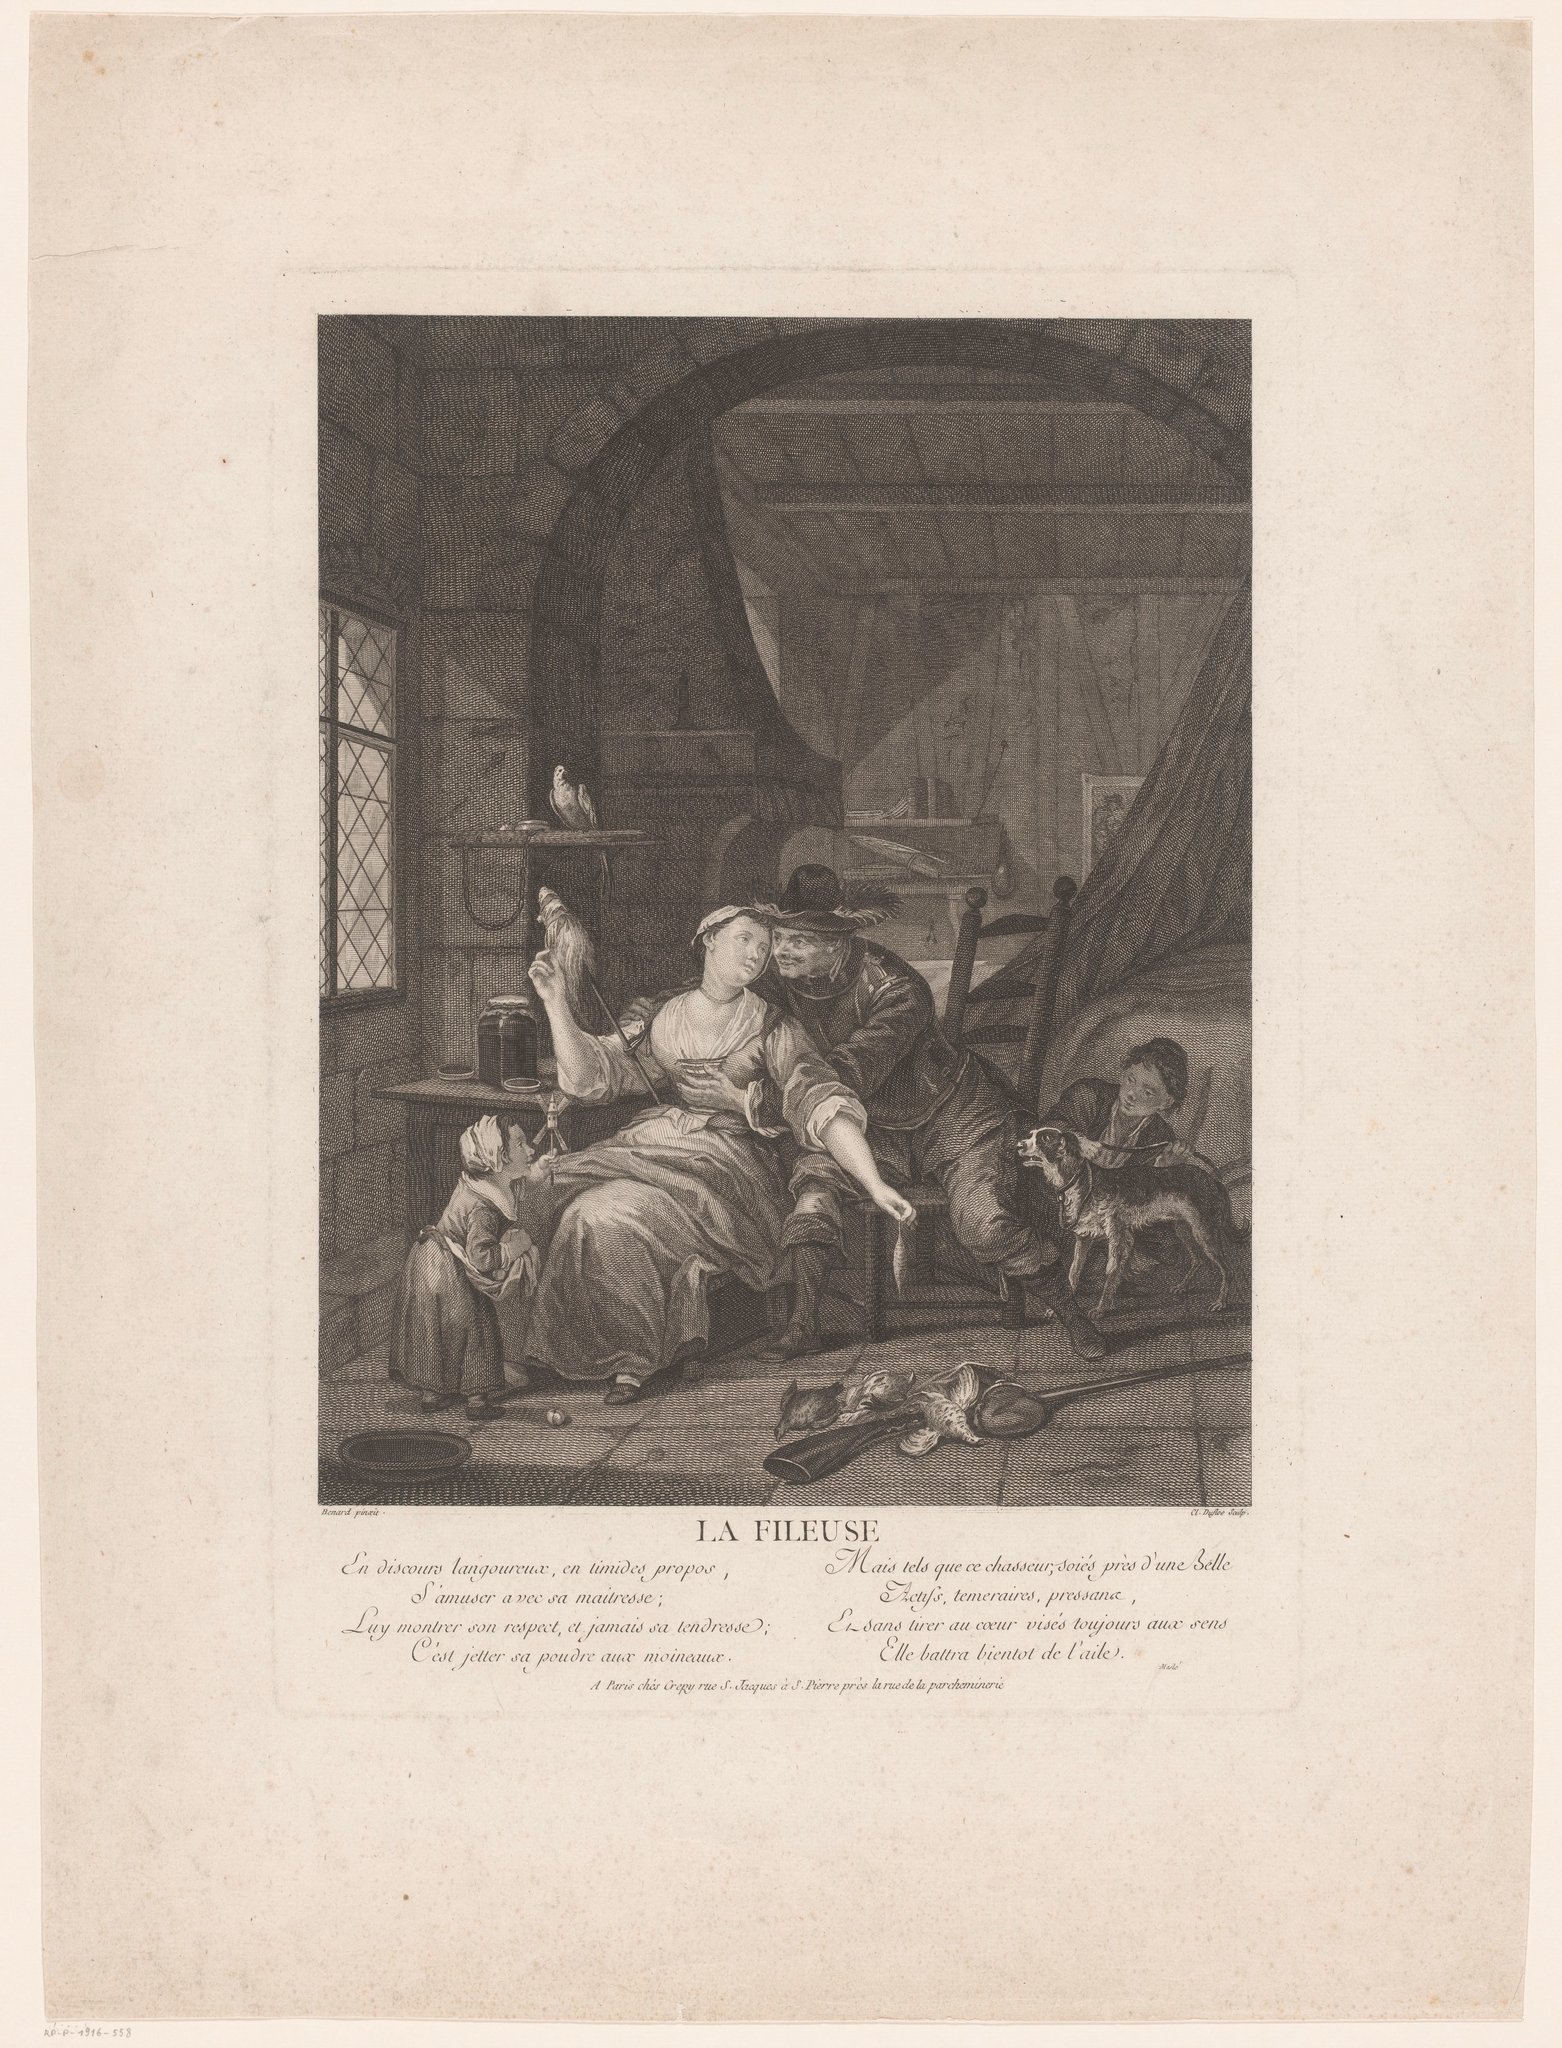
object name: print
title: La fileuse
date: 1710-1786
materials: paper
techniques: engraving, etching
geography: france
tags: embracing each other, kissing, interior of the house, (playing with) toy mills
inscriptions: collector's mark: Lugt 2228